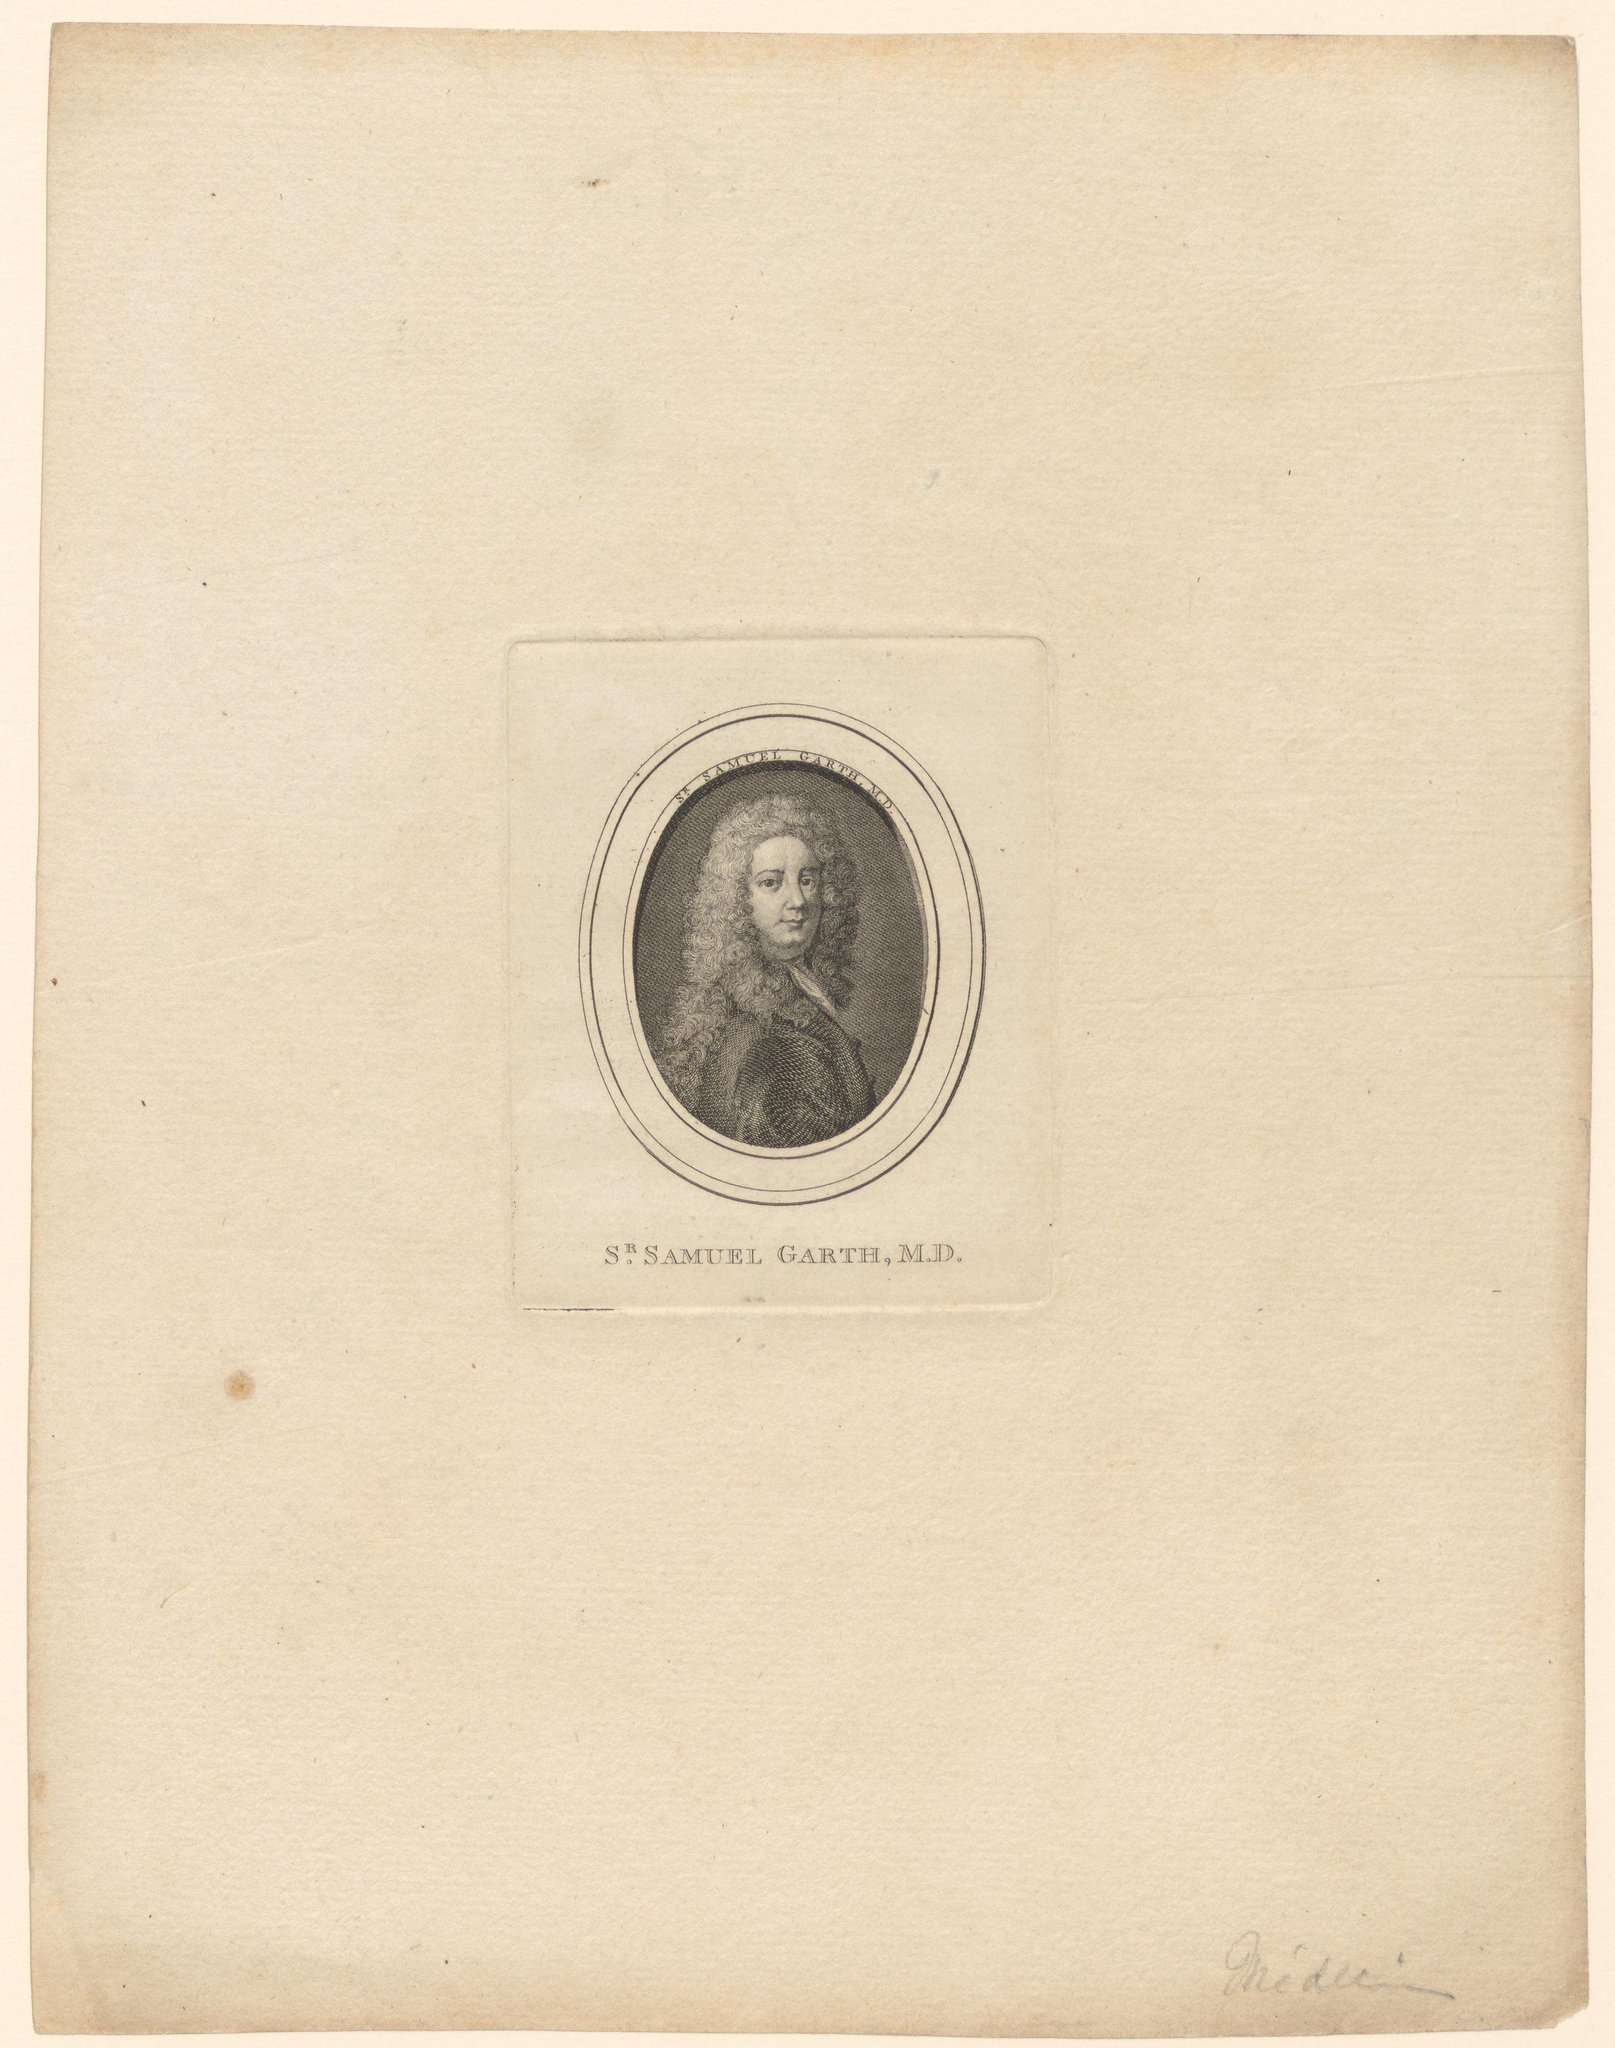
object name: print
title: Sr. Samuel Garth M.D.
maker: william walker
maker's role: print maker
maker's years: 1729-1793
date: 1739-1793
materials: paper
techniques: engraving, etching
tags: london, historical persons, physician, doctor (+ portrait of scholar, scientist)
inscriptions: collector's mark: Lugt 2228